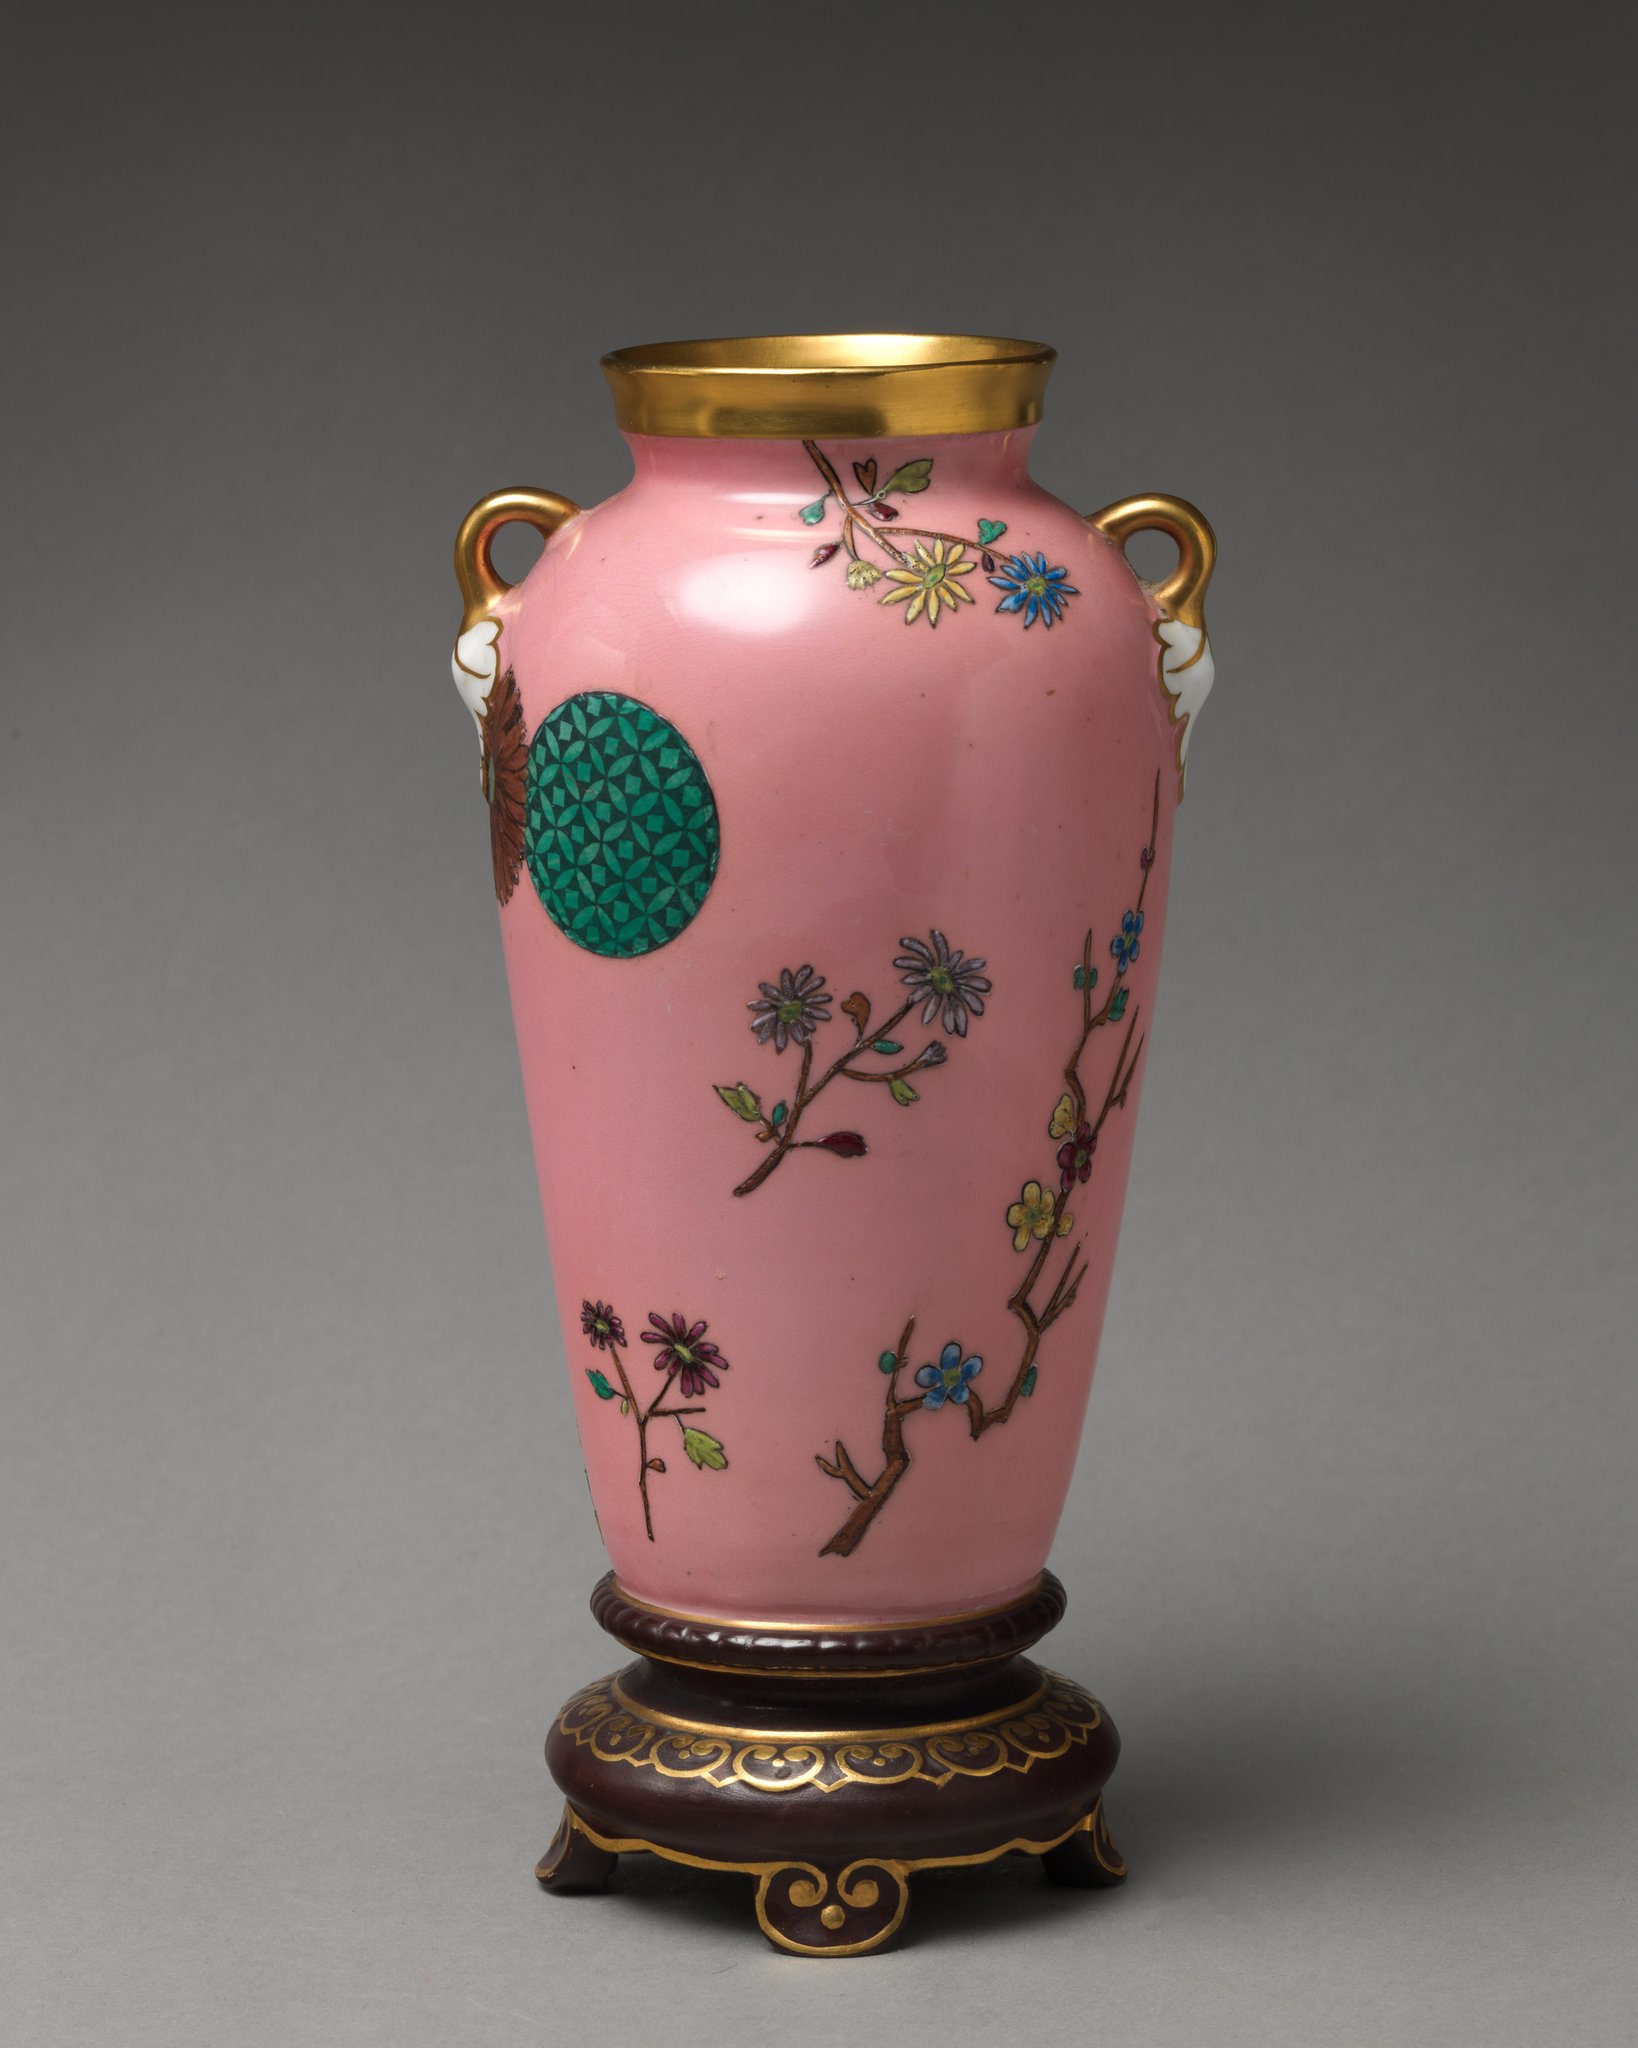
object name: vase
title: Vase with flowering branch motif (one of a pair)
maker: minton(s)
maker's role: maker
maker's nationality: british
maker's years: 1793-2001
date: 1872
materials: porcelain